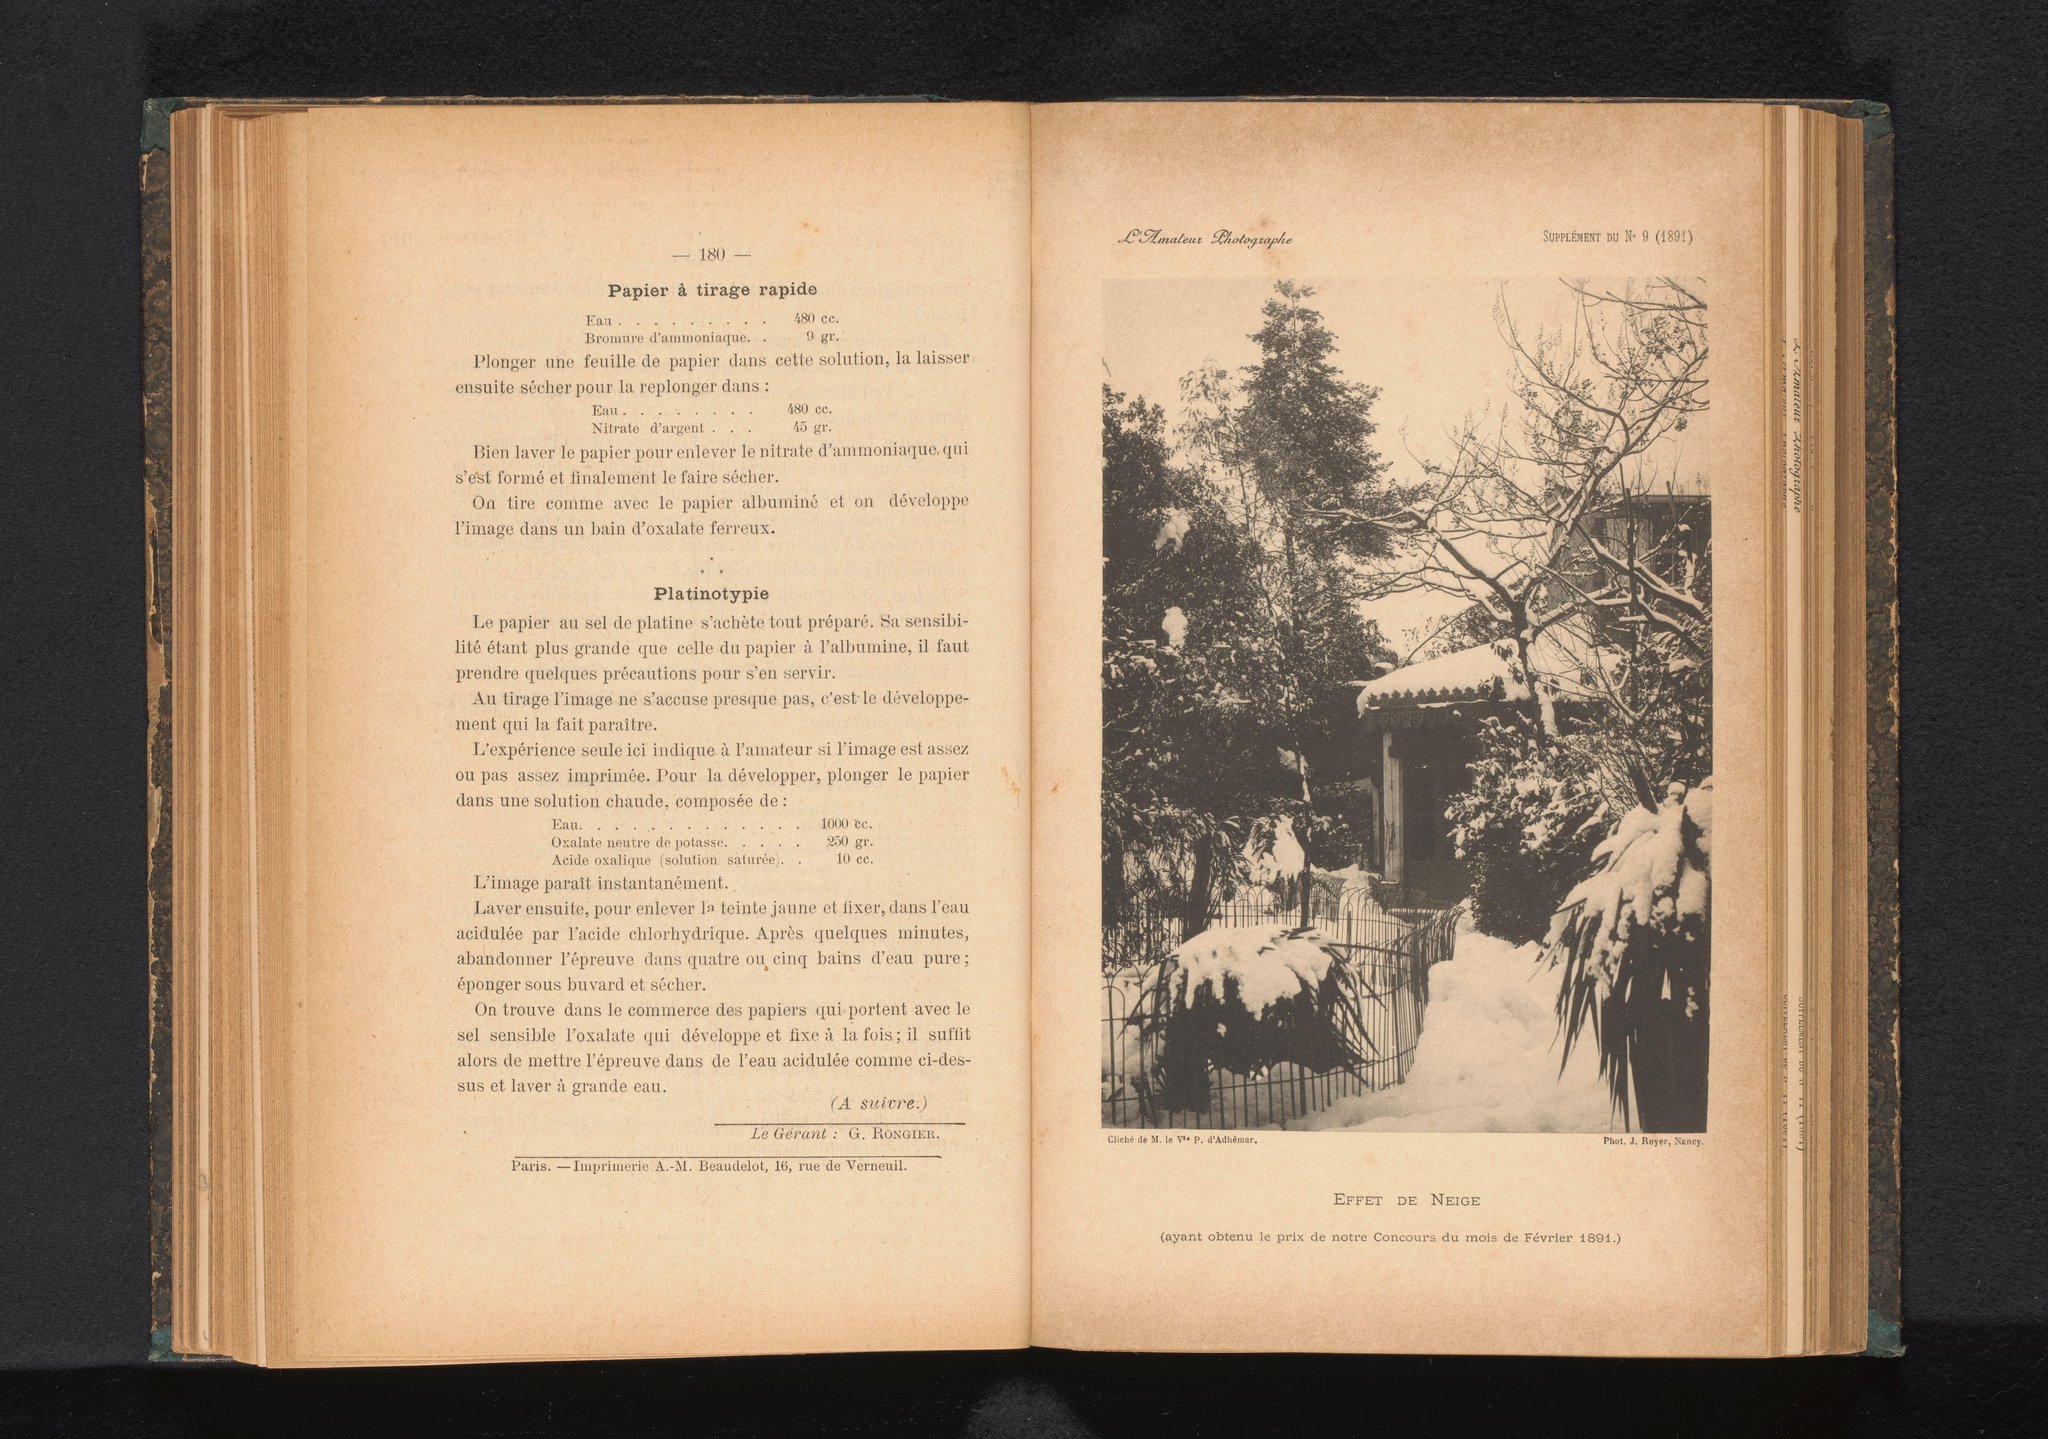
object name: page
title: Effet de neige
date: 1802-1891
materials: paper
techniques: photograph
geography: nancy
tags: garden, winter landscape; landscape symbolizing winter (the four seasons of the year)